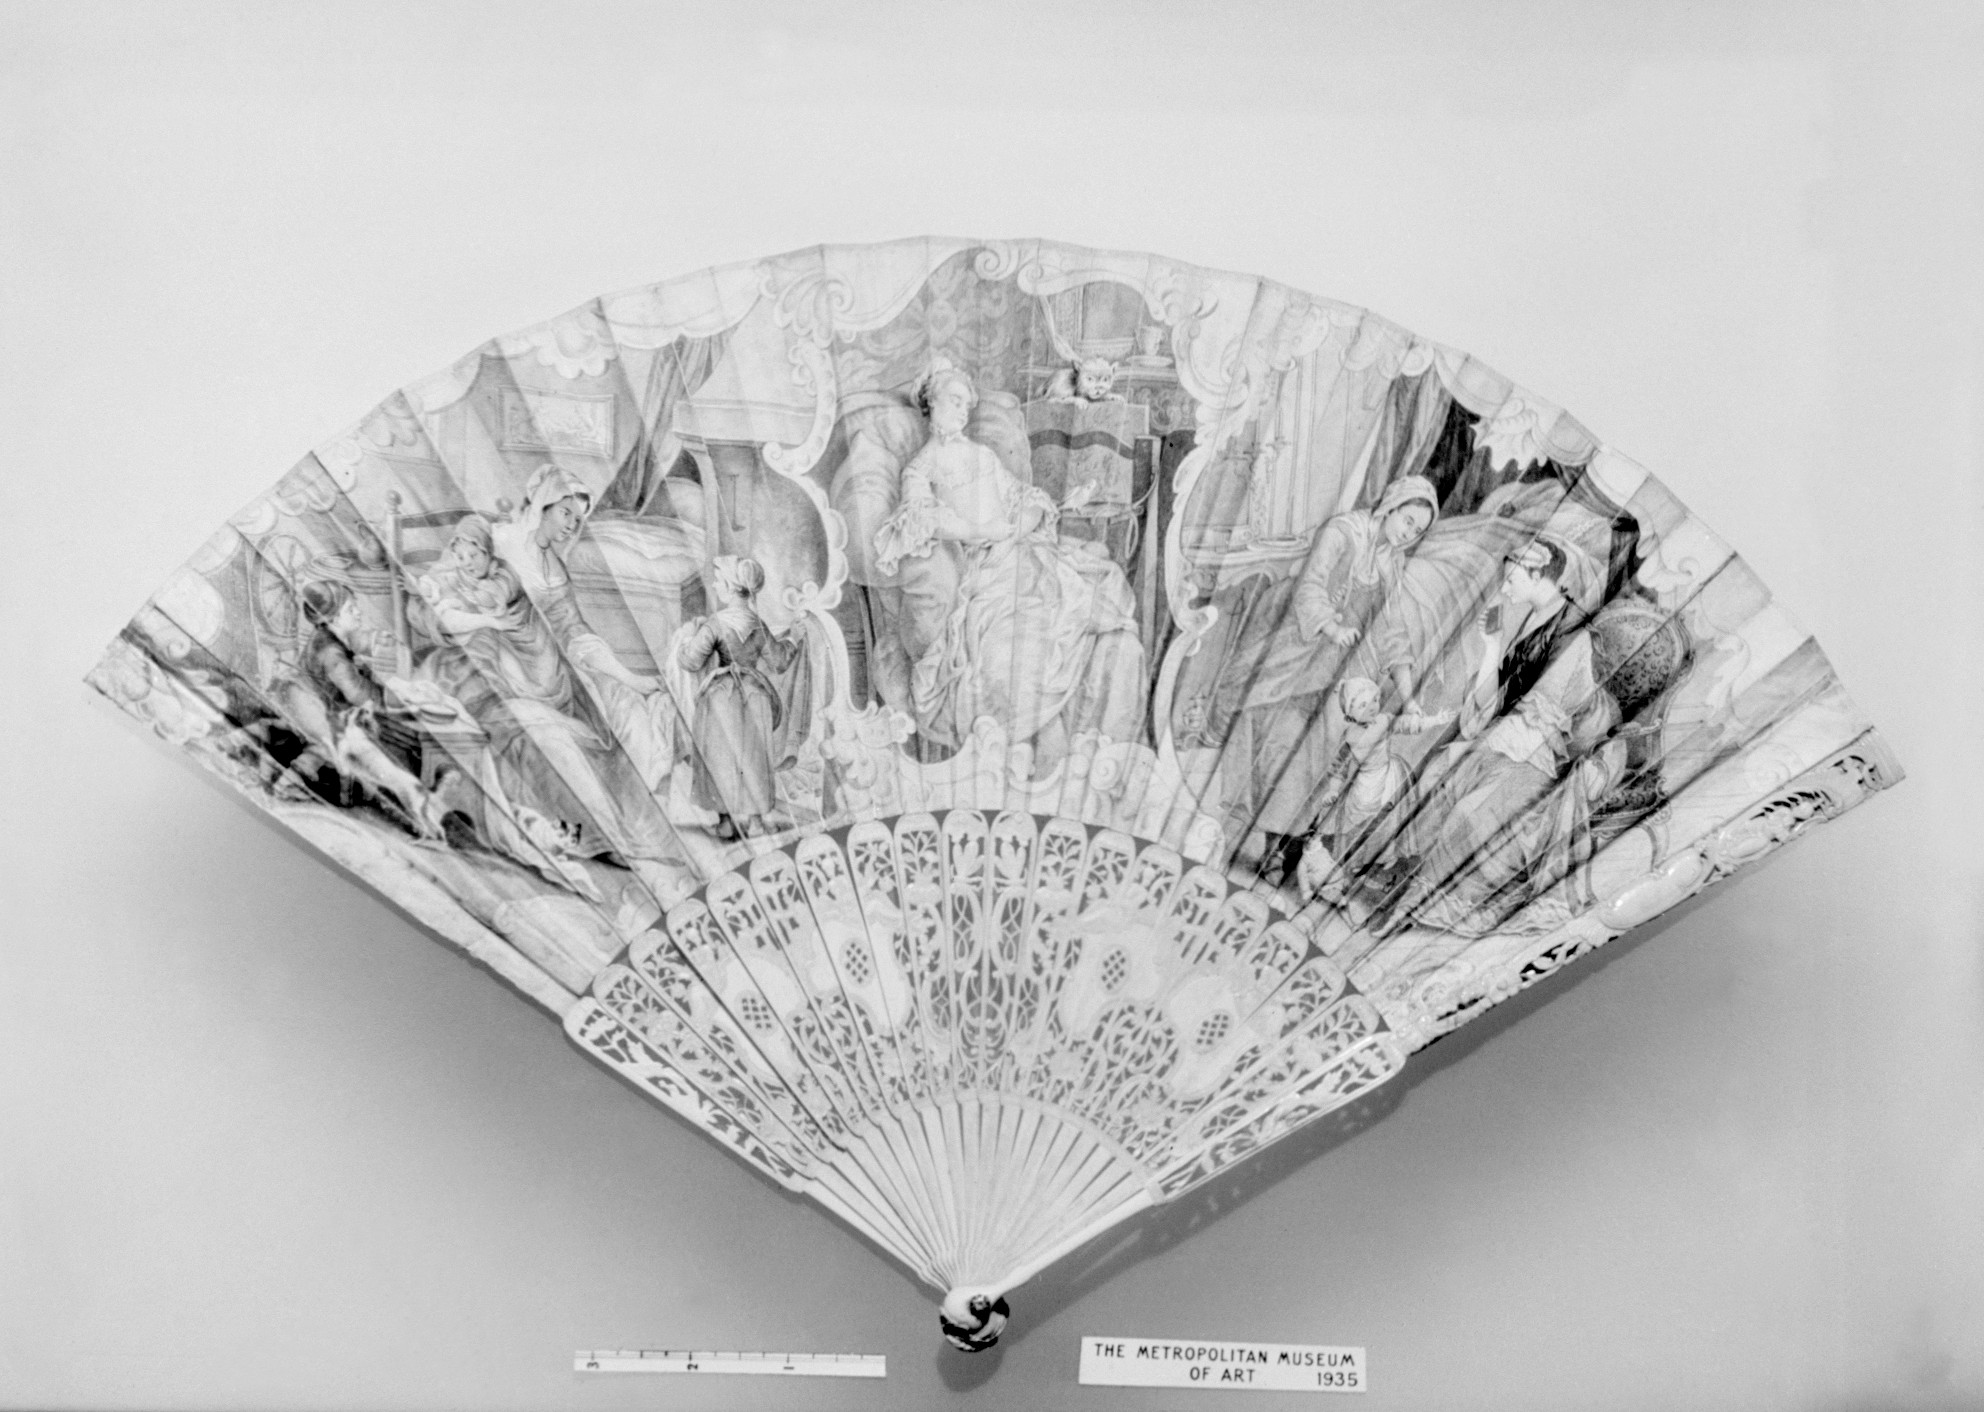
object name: fan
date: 1751-1775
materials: ivory, skin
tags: girls,infants,women